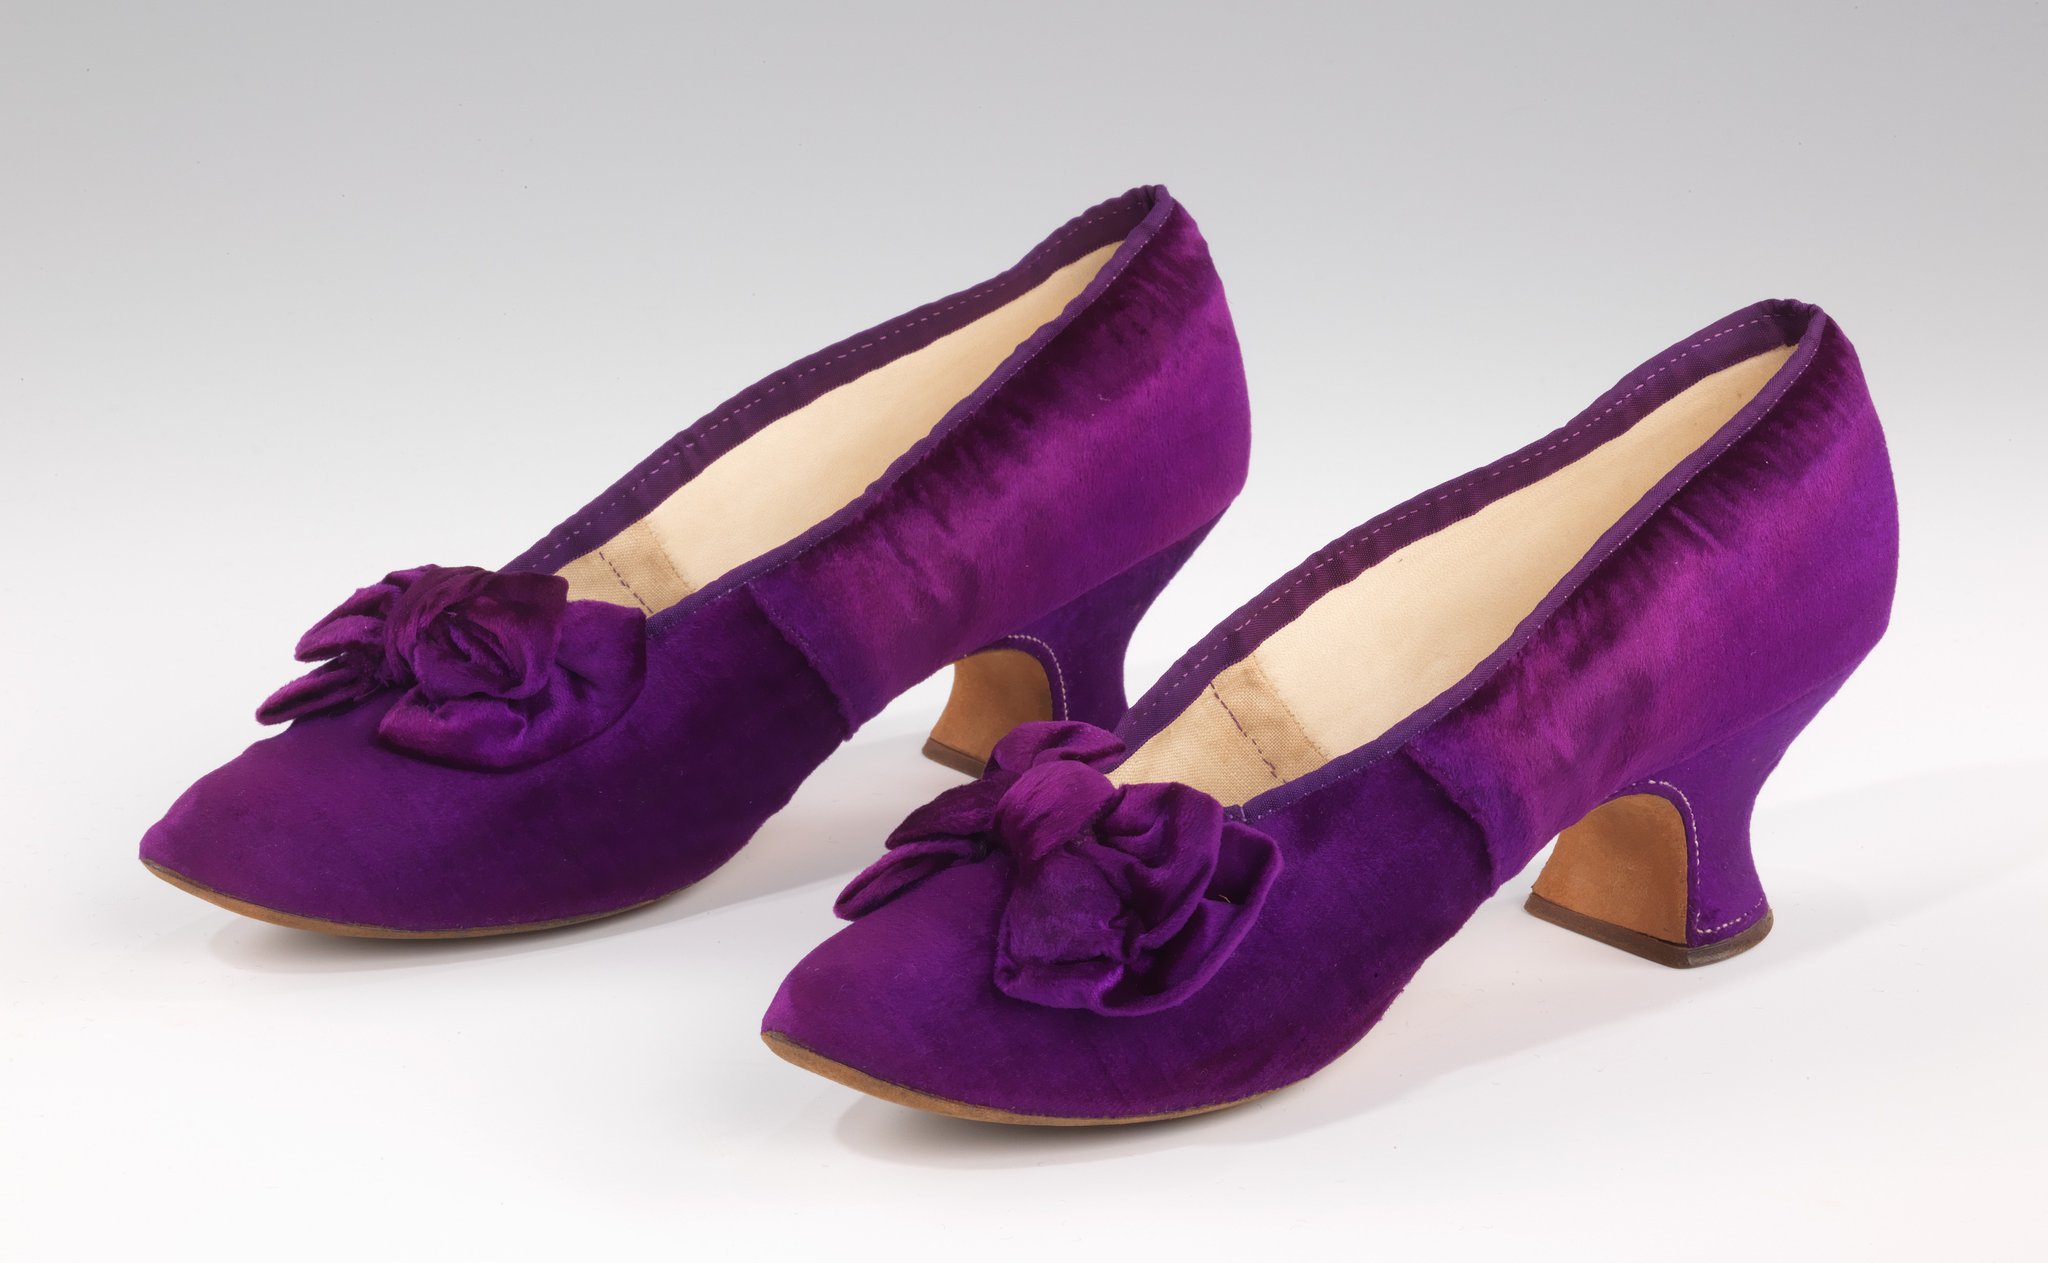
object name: evening slipper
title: Evening slippers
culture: french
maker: j. ferry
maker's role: department store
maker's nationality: french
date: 1885-1890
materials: silk